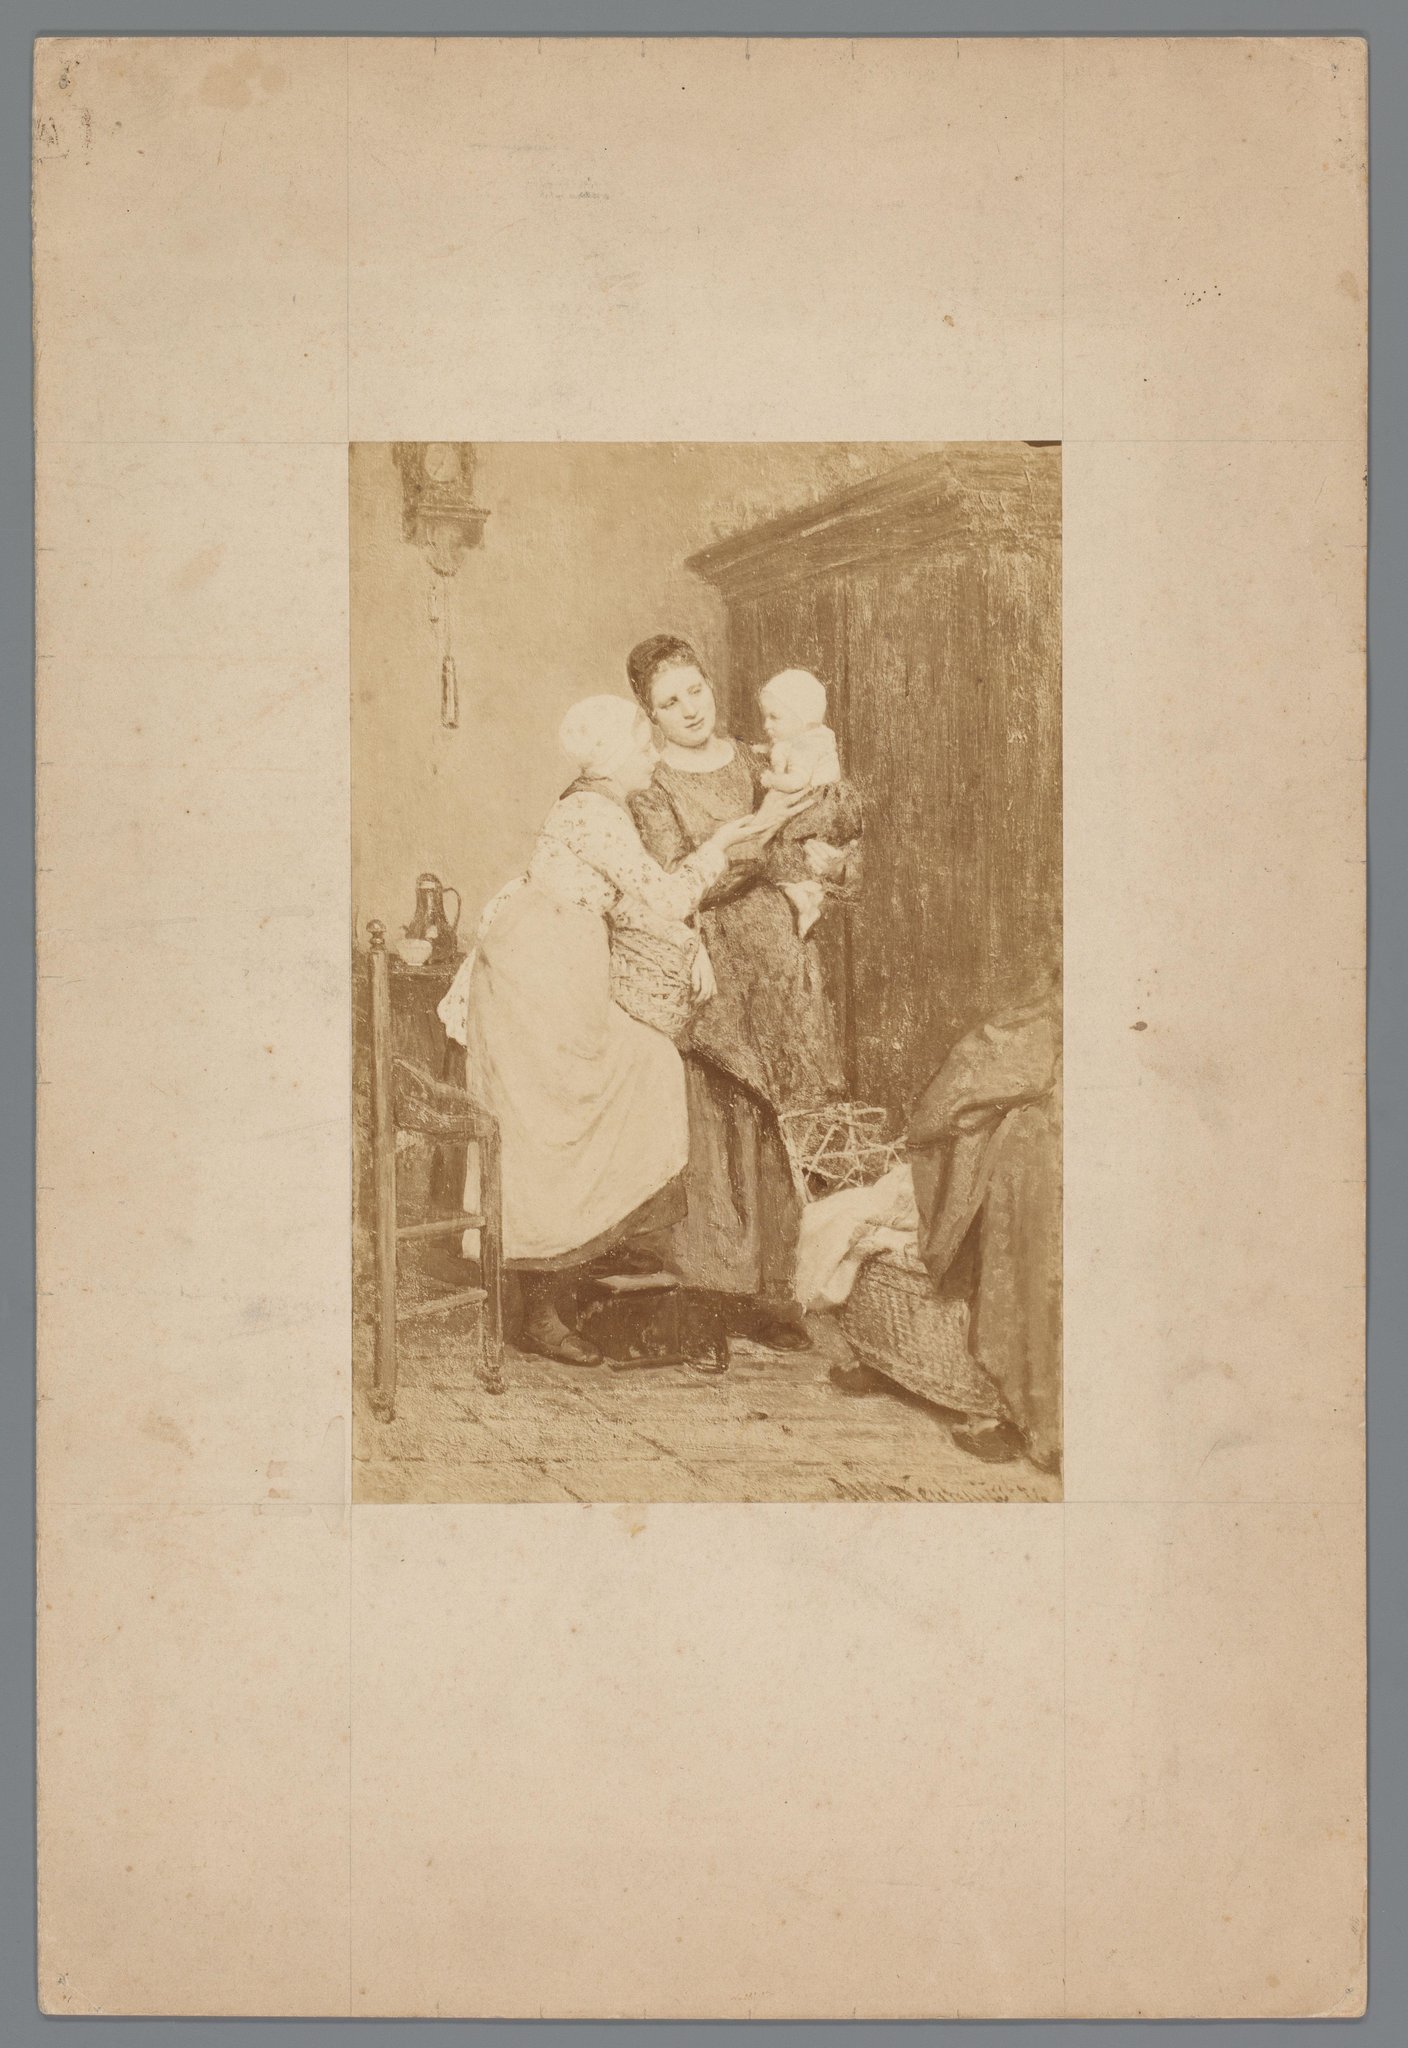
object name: photograph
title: Schilderij van Albert Neuhuys met daarop twee jonge vrouwen en een baby in een huiskamer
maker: Anonymous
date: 1880-1914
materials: paper, photographic support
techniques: matte daylight collodion silver print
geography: netherlands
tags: utrecht, print maker, draughtsman, albert neuhuys (1844-1914)